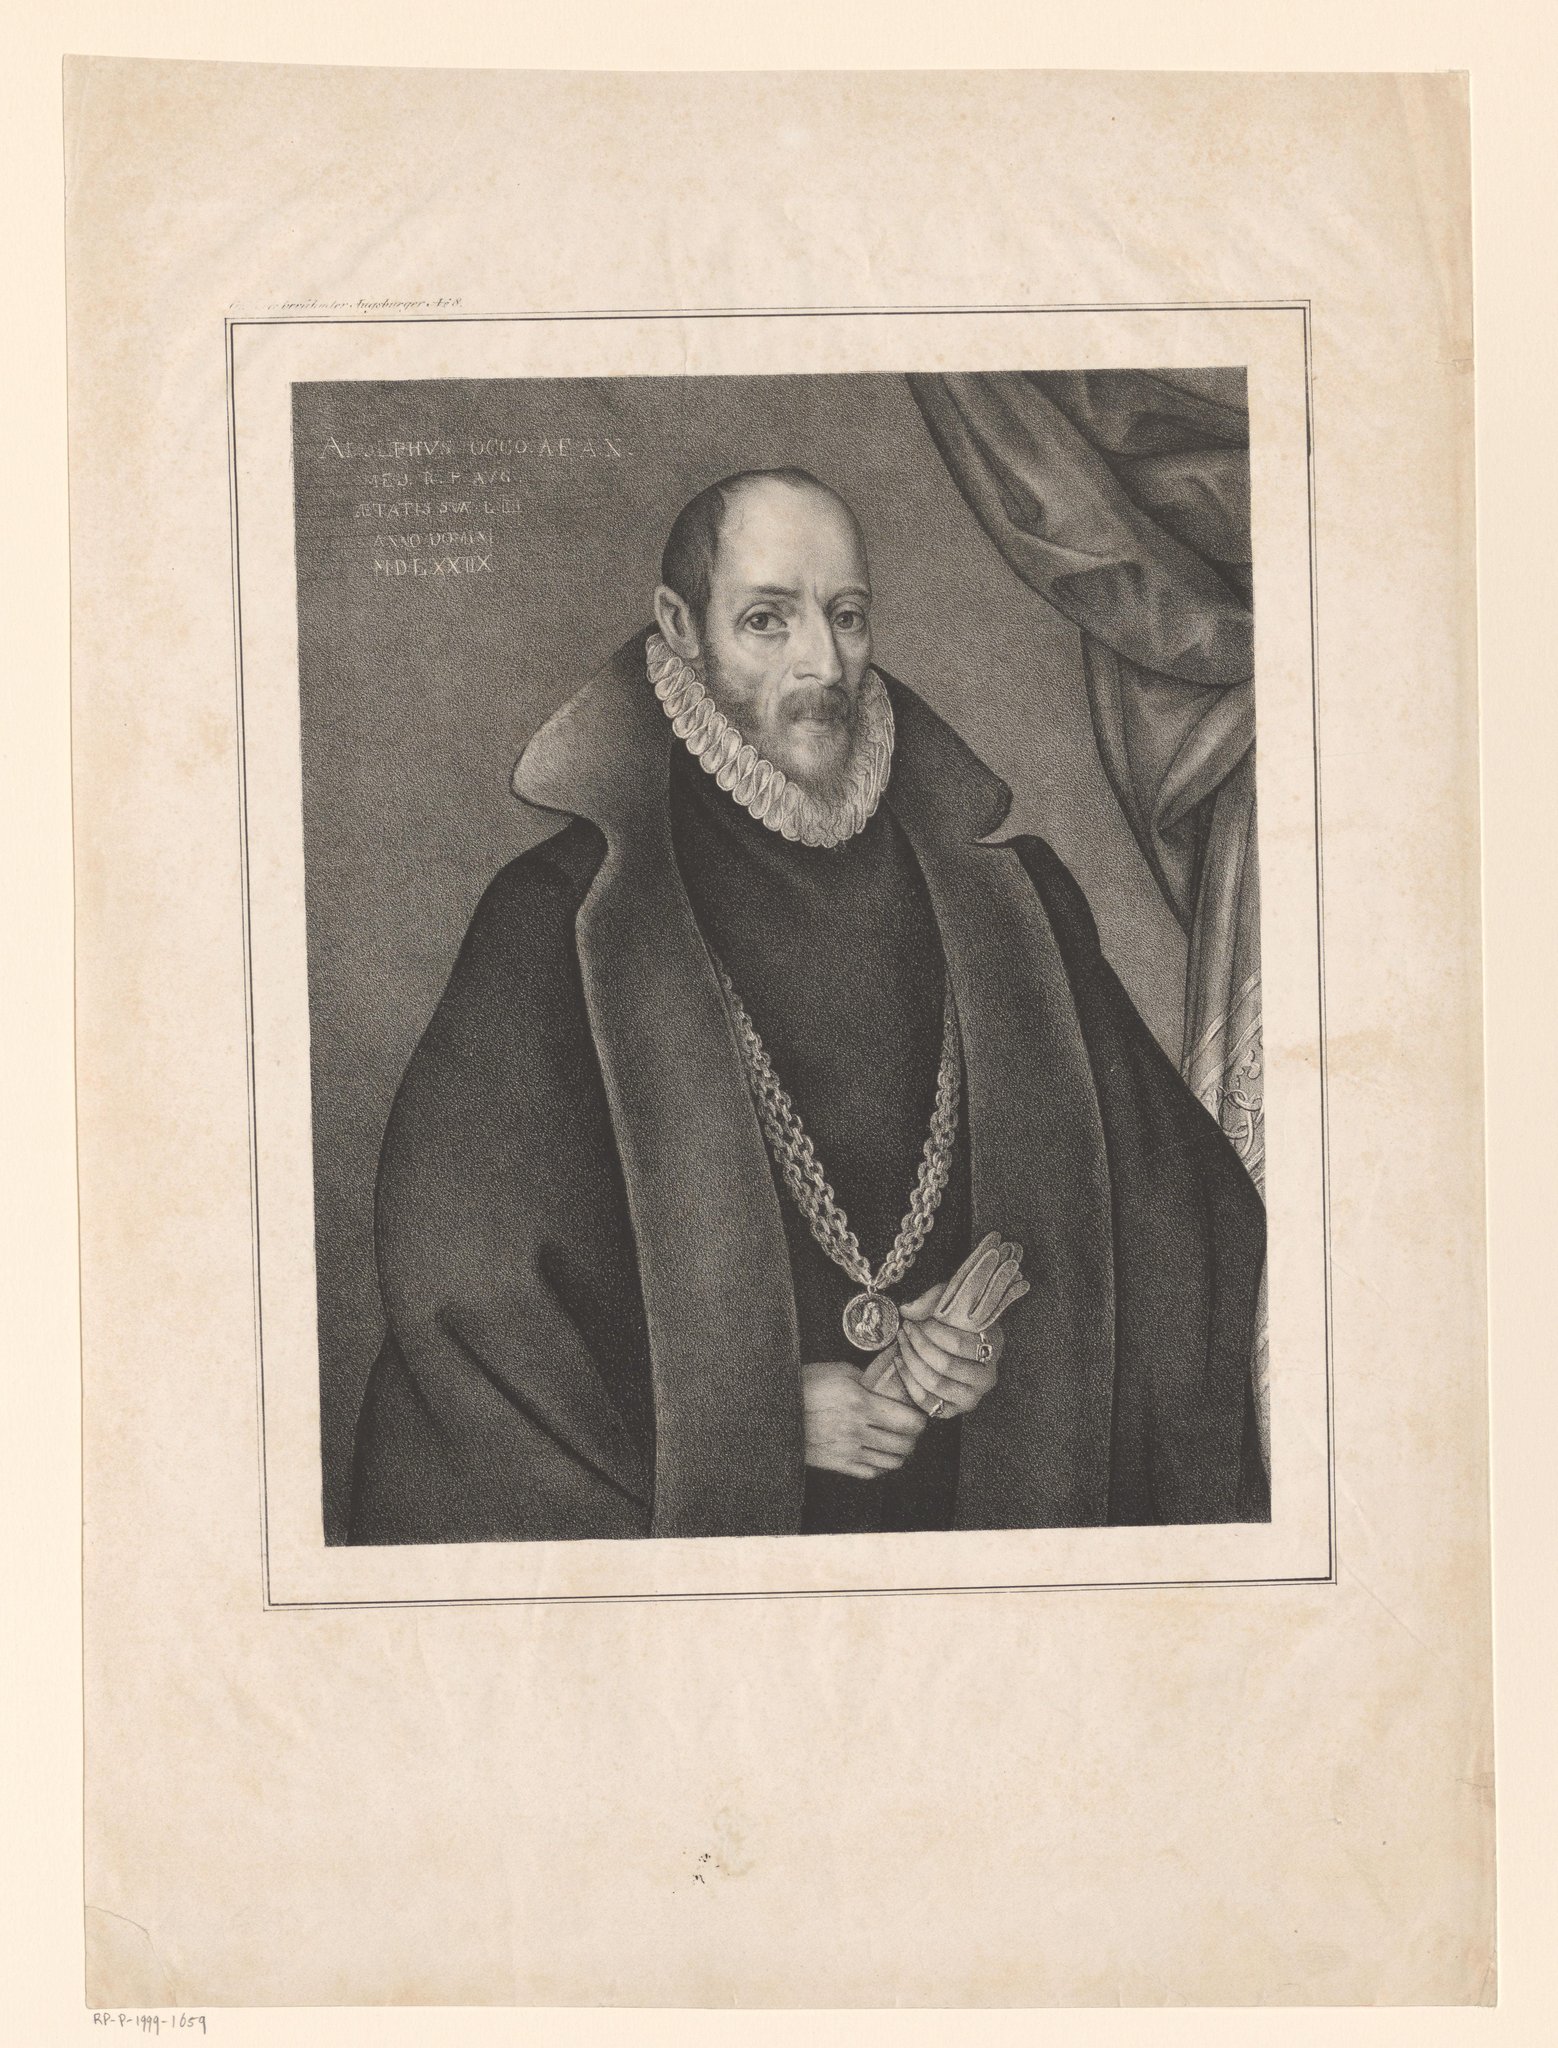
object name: print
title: Portret van Adolph Occo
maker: Anonymous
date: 1830-1874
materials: paper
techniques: lithograph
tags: augsburg, adolph occo (iii), gloves, mittens, etc., adult man, historical persons, knighthood order of the golden fleece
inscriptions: collector's mark: Lugt 4100, collector's mark: Lugt 2760, collector's mark: Lugt 2228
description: Linksboven: Gallerie Berühmter Augsburger Nr 8.